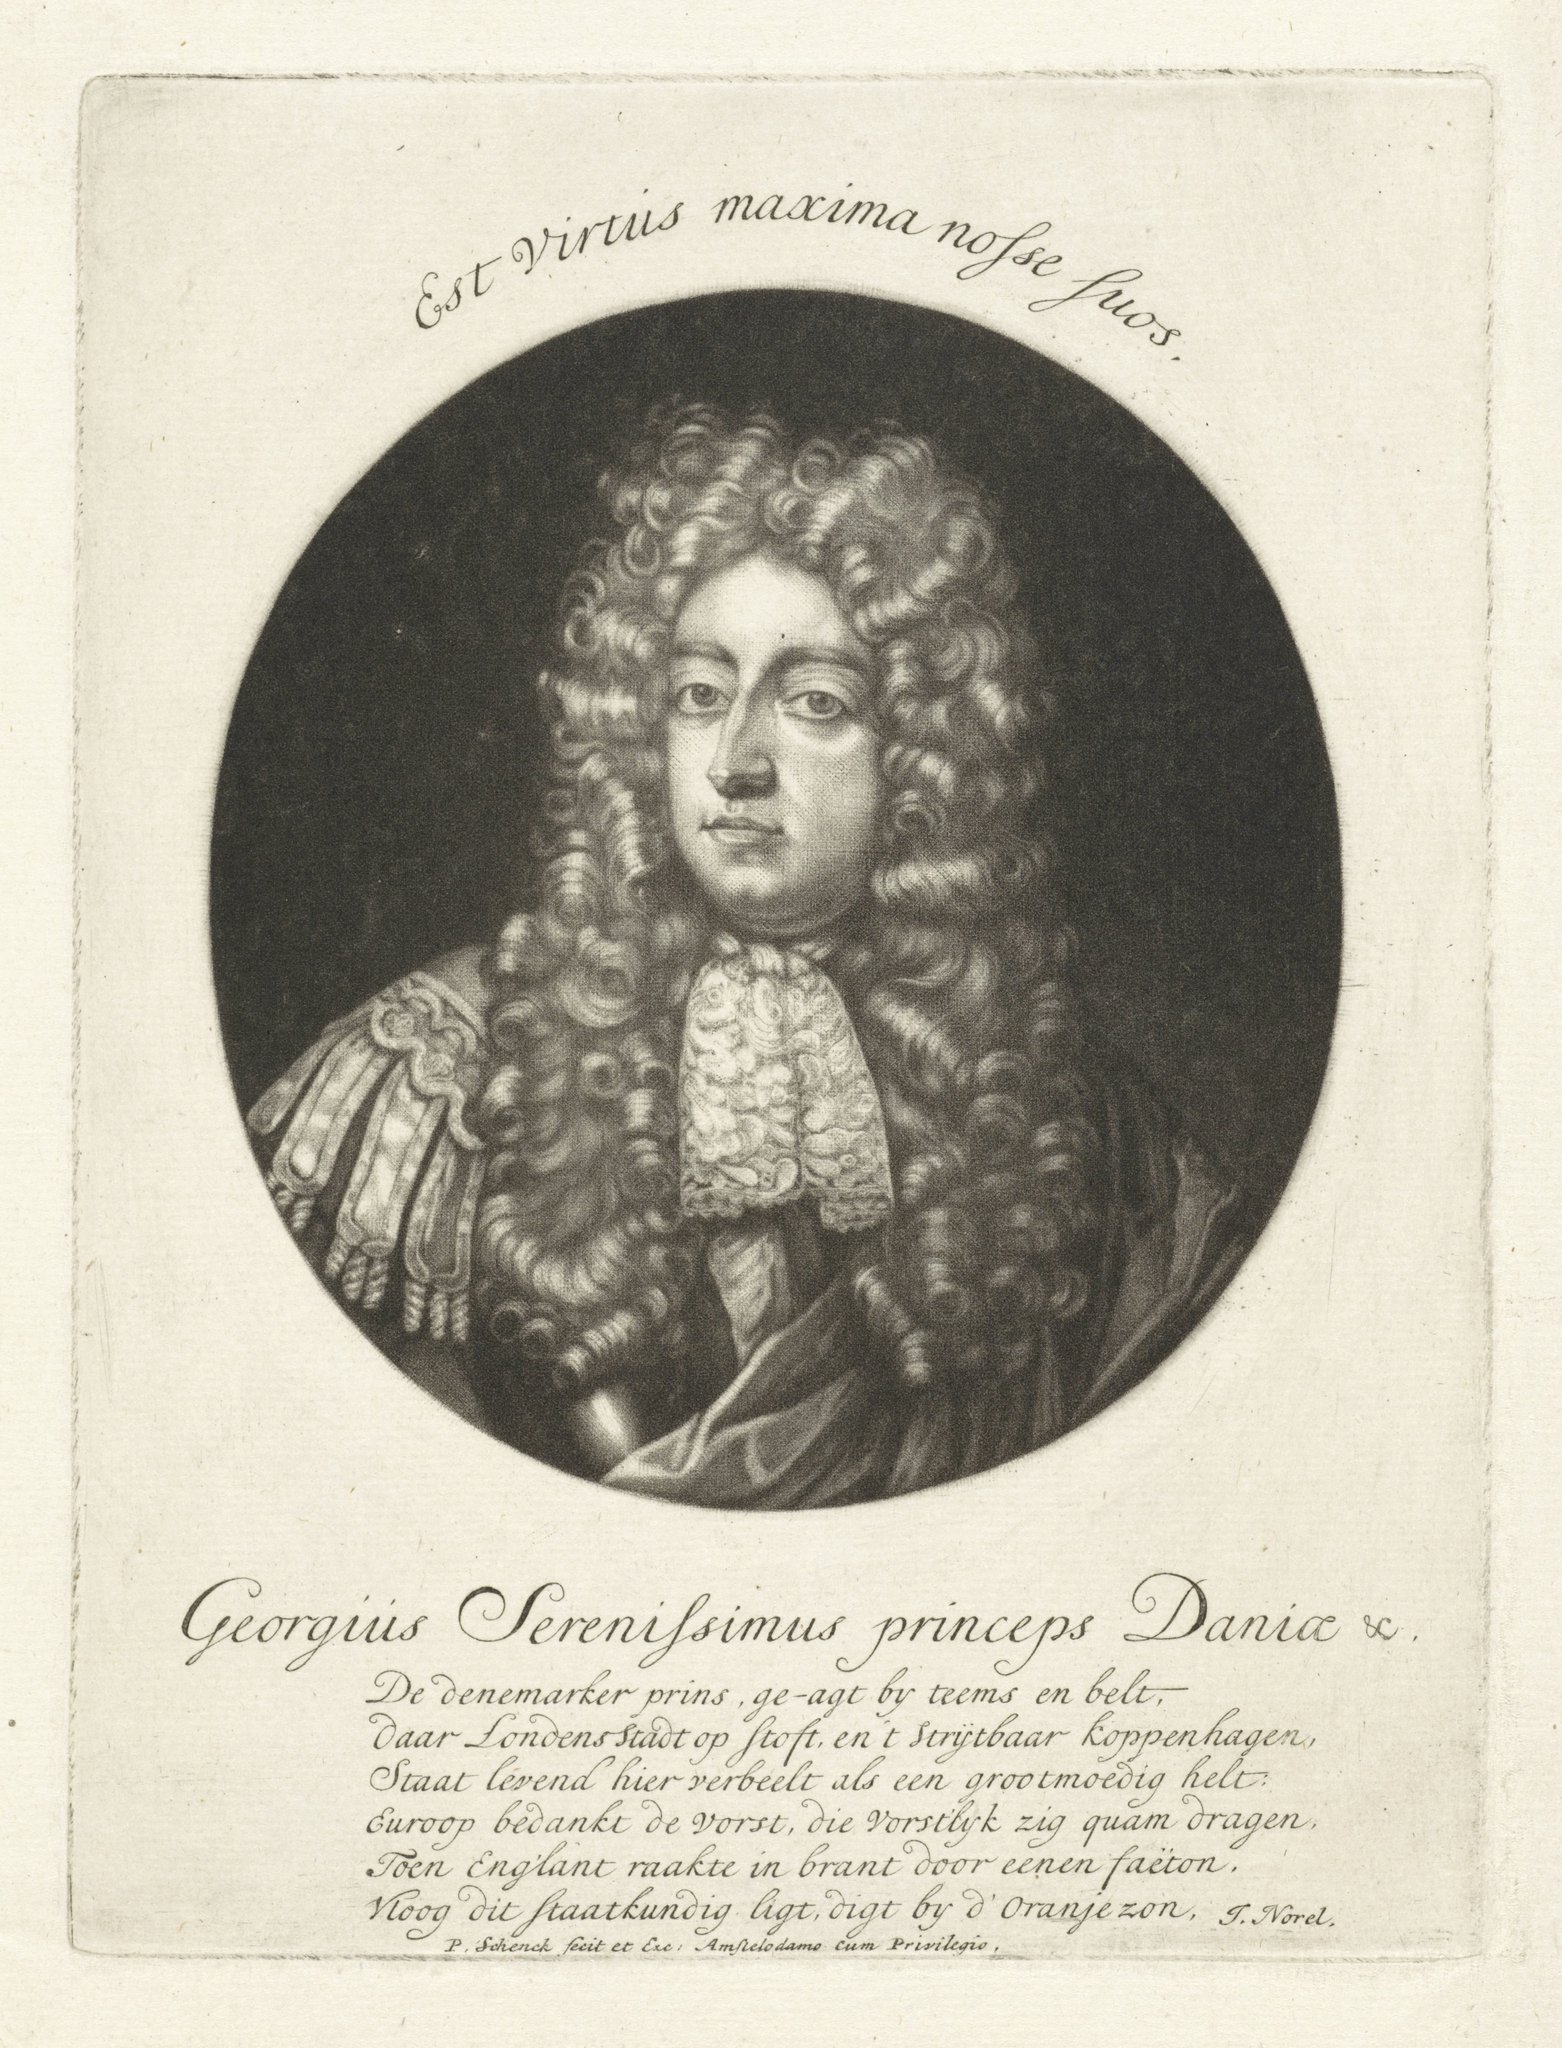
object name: print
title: Portret van George, prins van Denemarken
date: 1670-1713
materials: paper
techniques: engraving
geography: amsterdam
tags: george (prins van denemarken), wig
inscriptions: collector's mark: Lugt 2228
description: George, prins van Denemarken, hertog van Cumberland en koning-gemaal van koningin Anna van Engeland. Hij draagt een lange krulpruik.